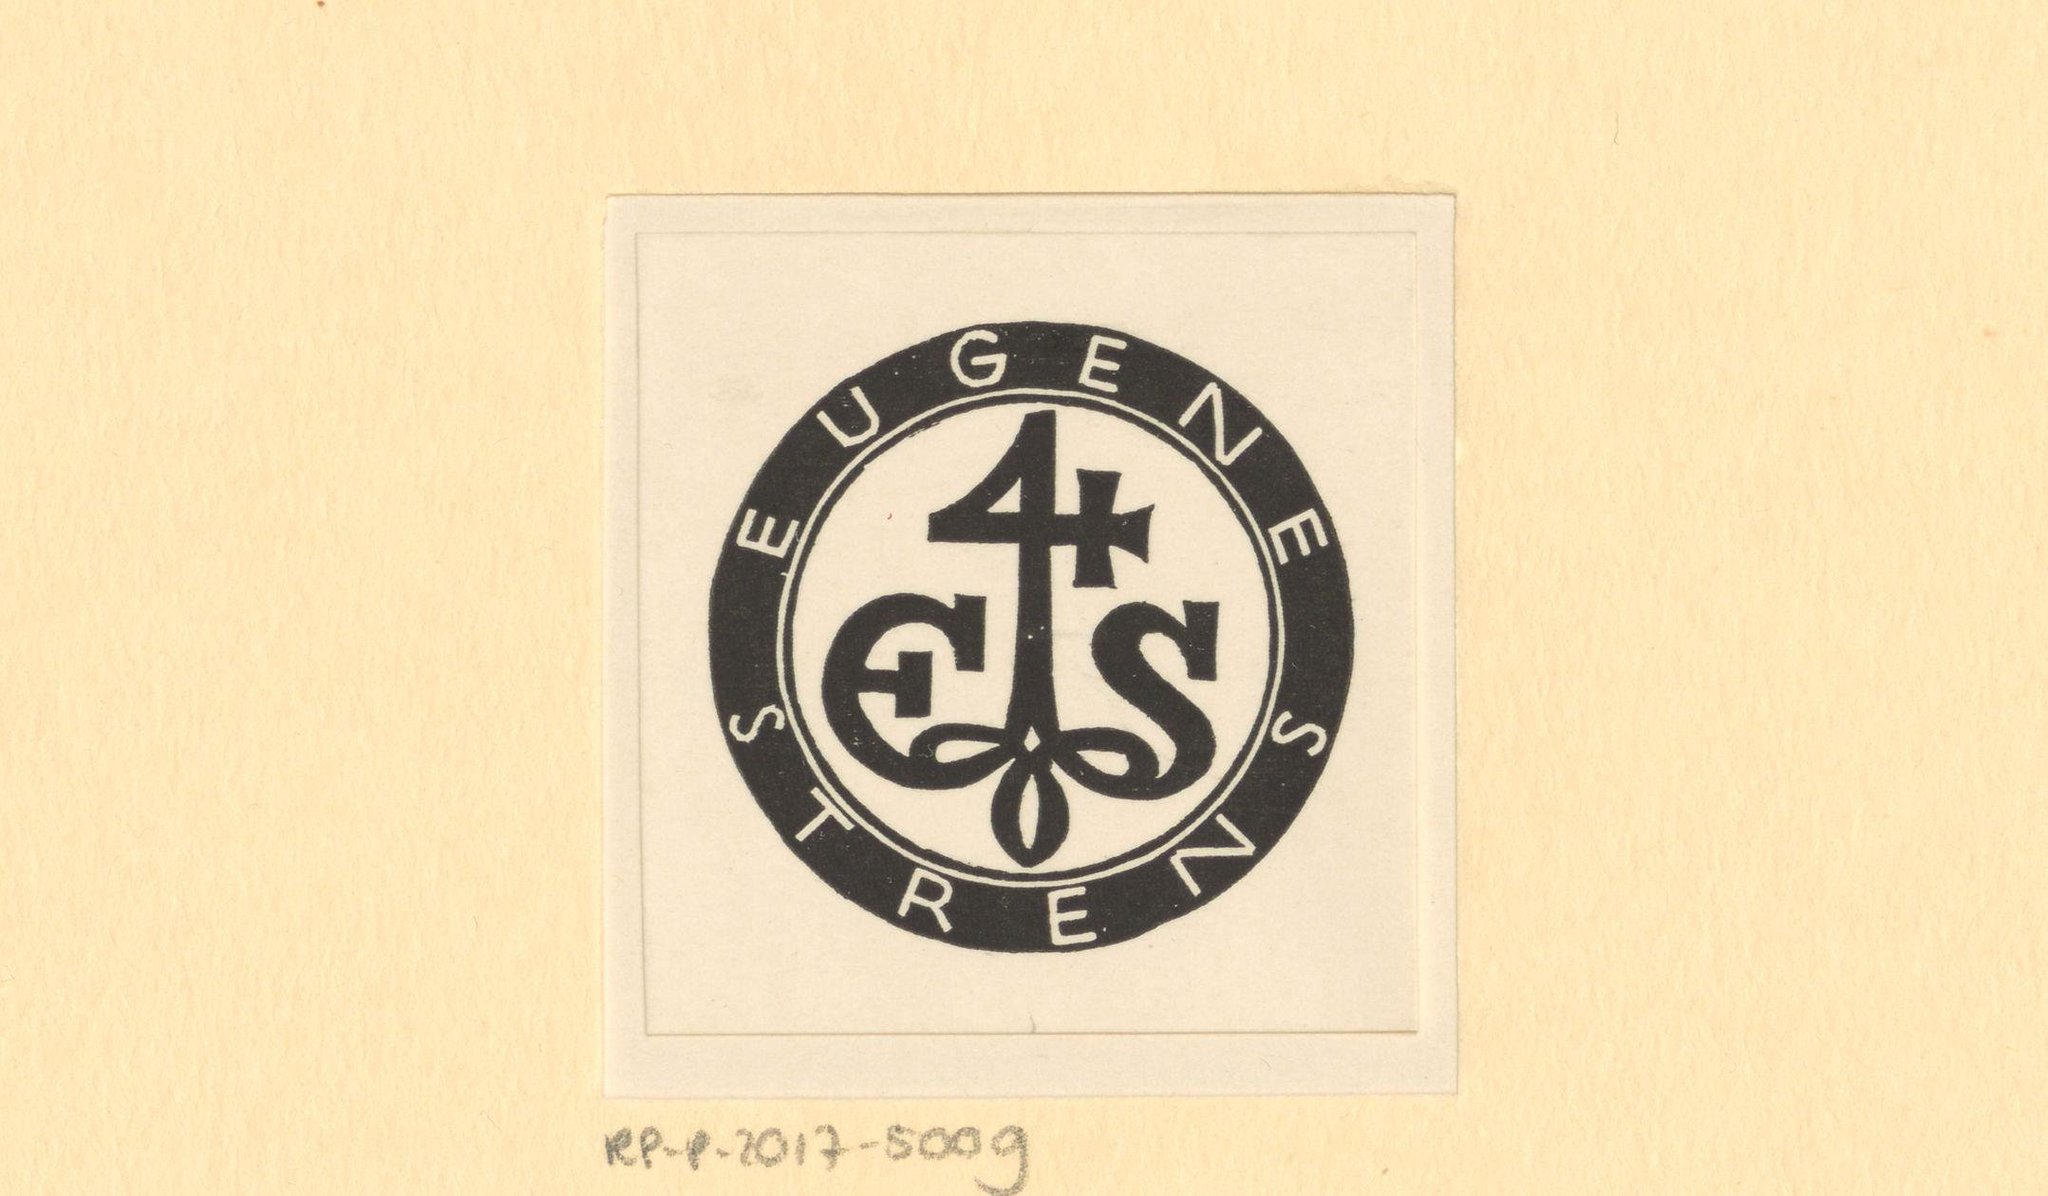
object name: bookplate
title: Ex libris van Eugene Strens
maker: karl michel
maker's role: painter, print maker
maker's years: 1885-1966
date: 1930-1949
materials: paper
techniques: linocut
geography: germany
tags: engineer, eugène louis charles marie strens, specific forms of the cross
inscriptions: workshop stamp: ‘Karl Michel; Holzschnitt’